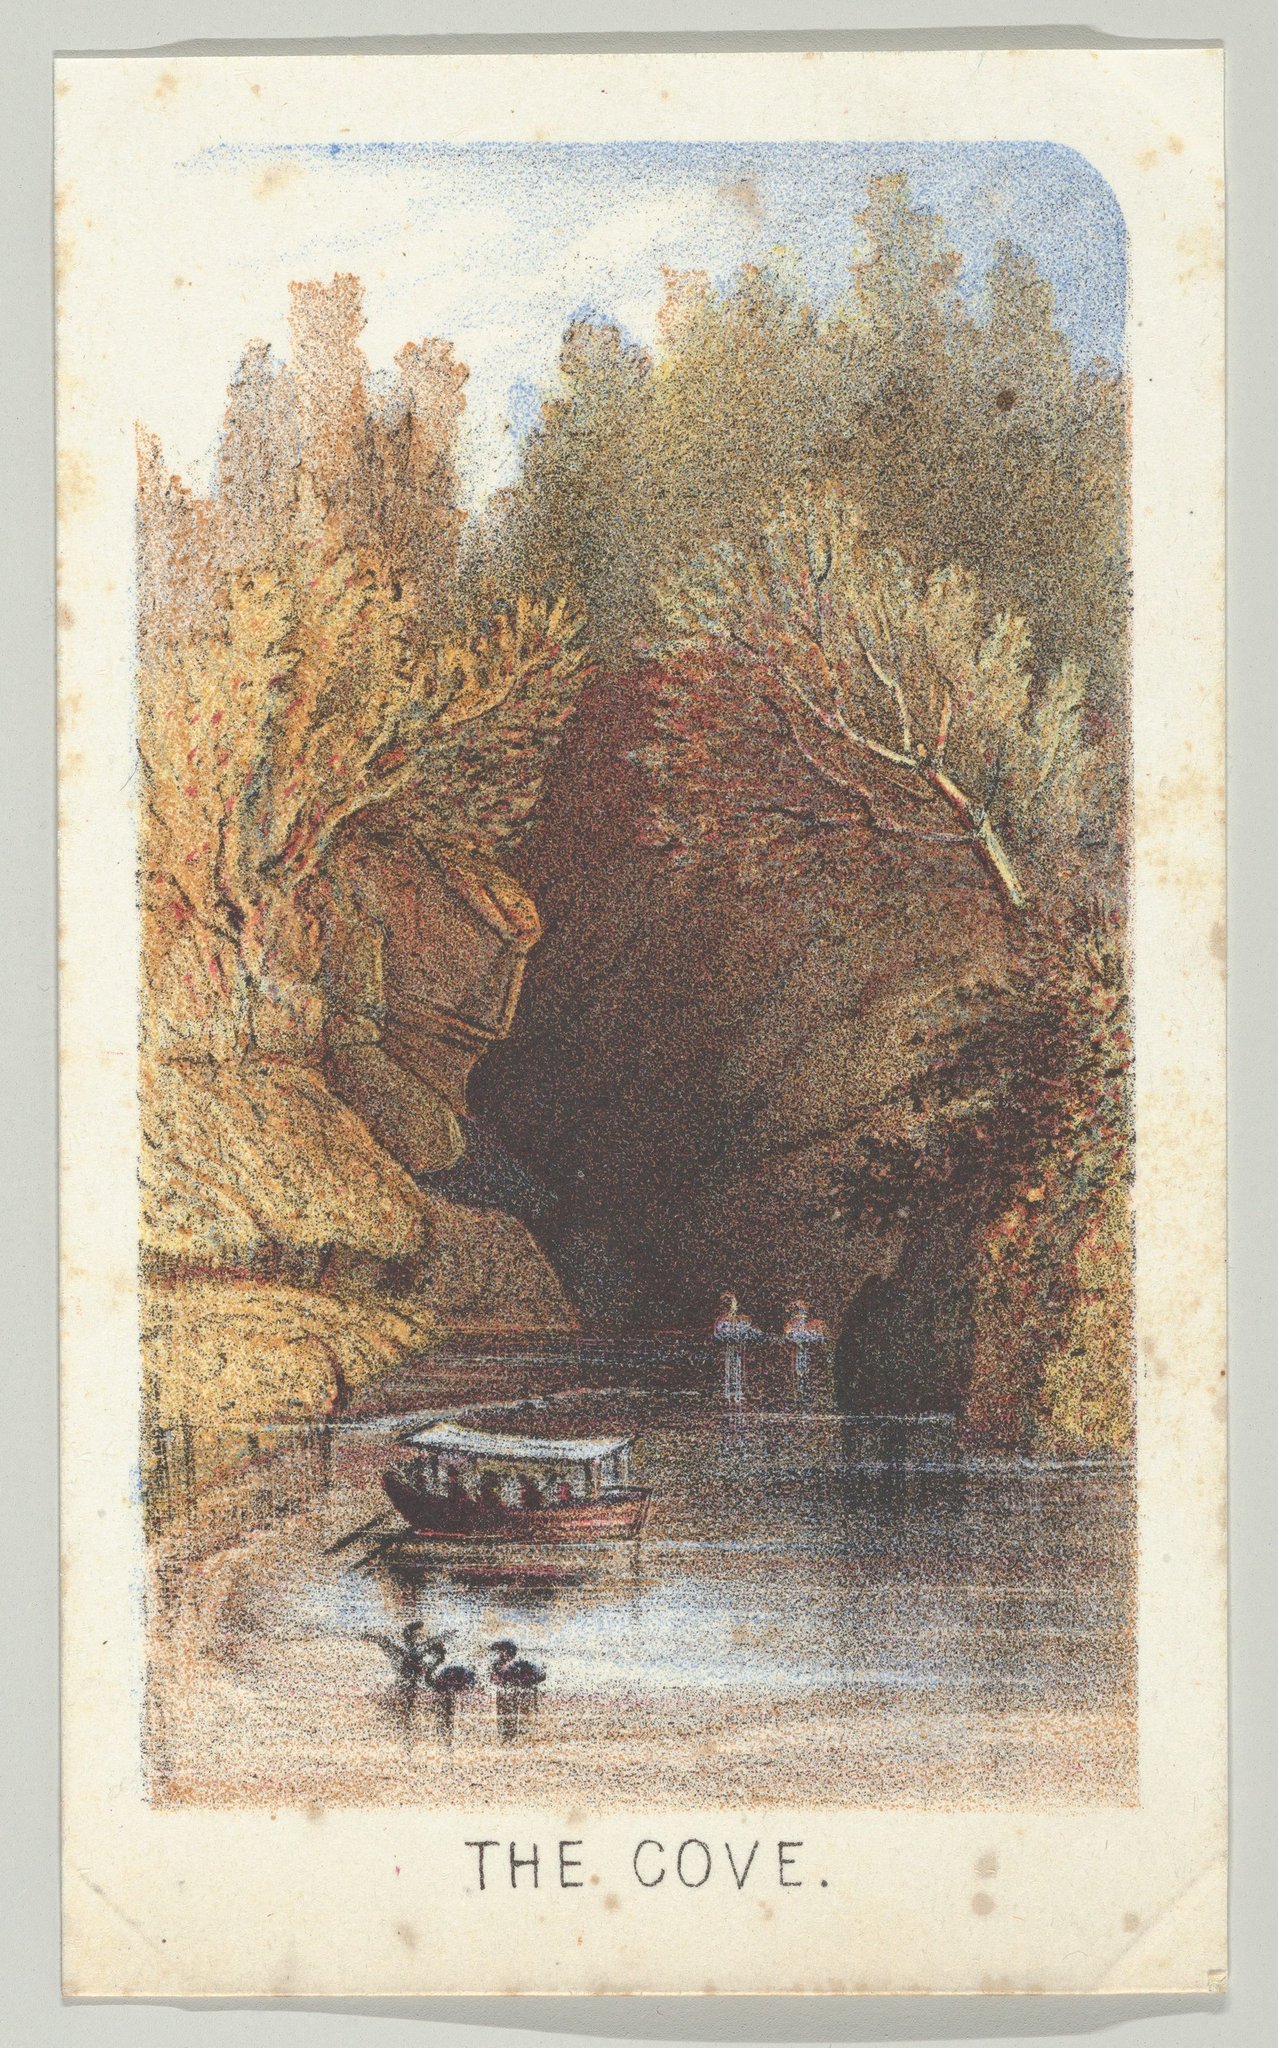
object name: print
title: The Cove, from the series, Views in Central Park, New York, Part 3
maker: louis prang & co.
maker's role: publisher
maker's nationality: american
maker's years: 1800-1950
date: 1864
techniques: lithograph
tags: ducks,parks,boats